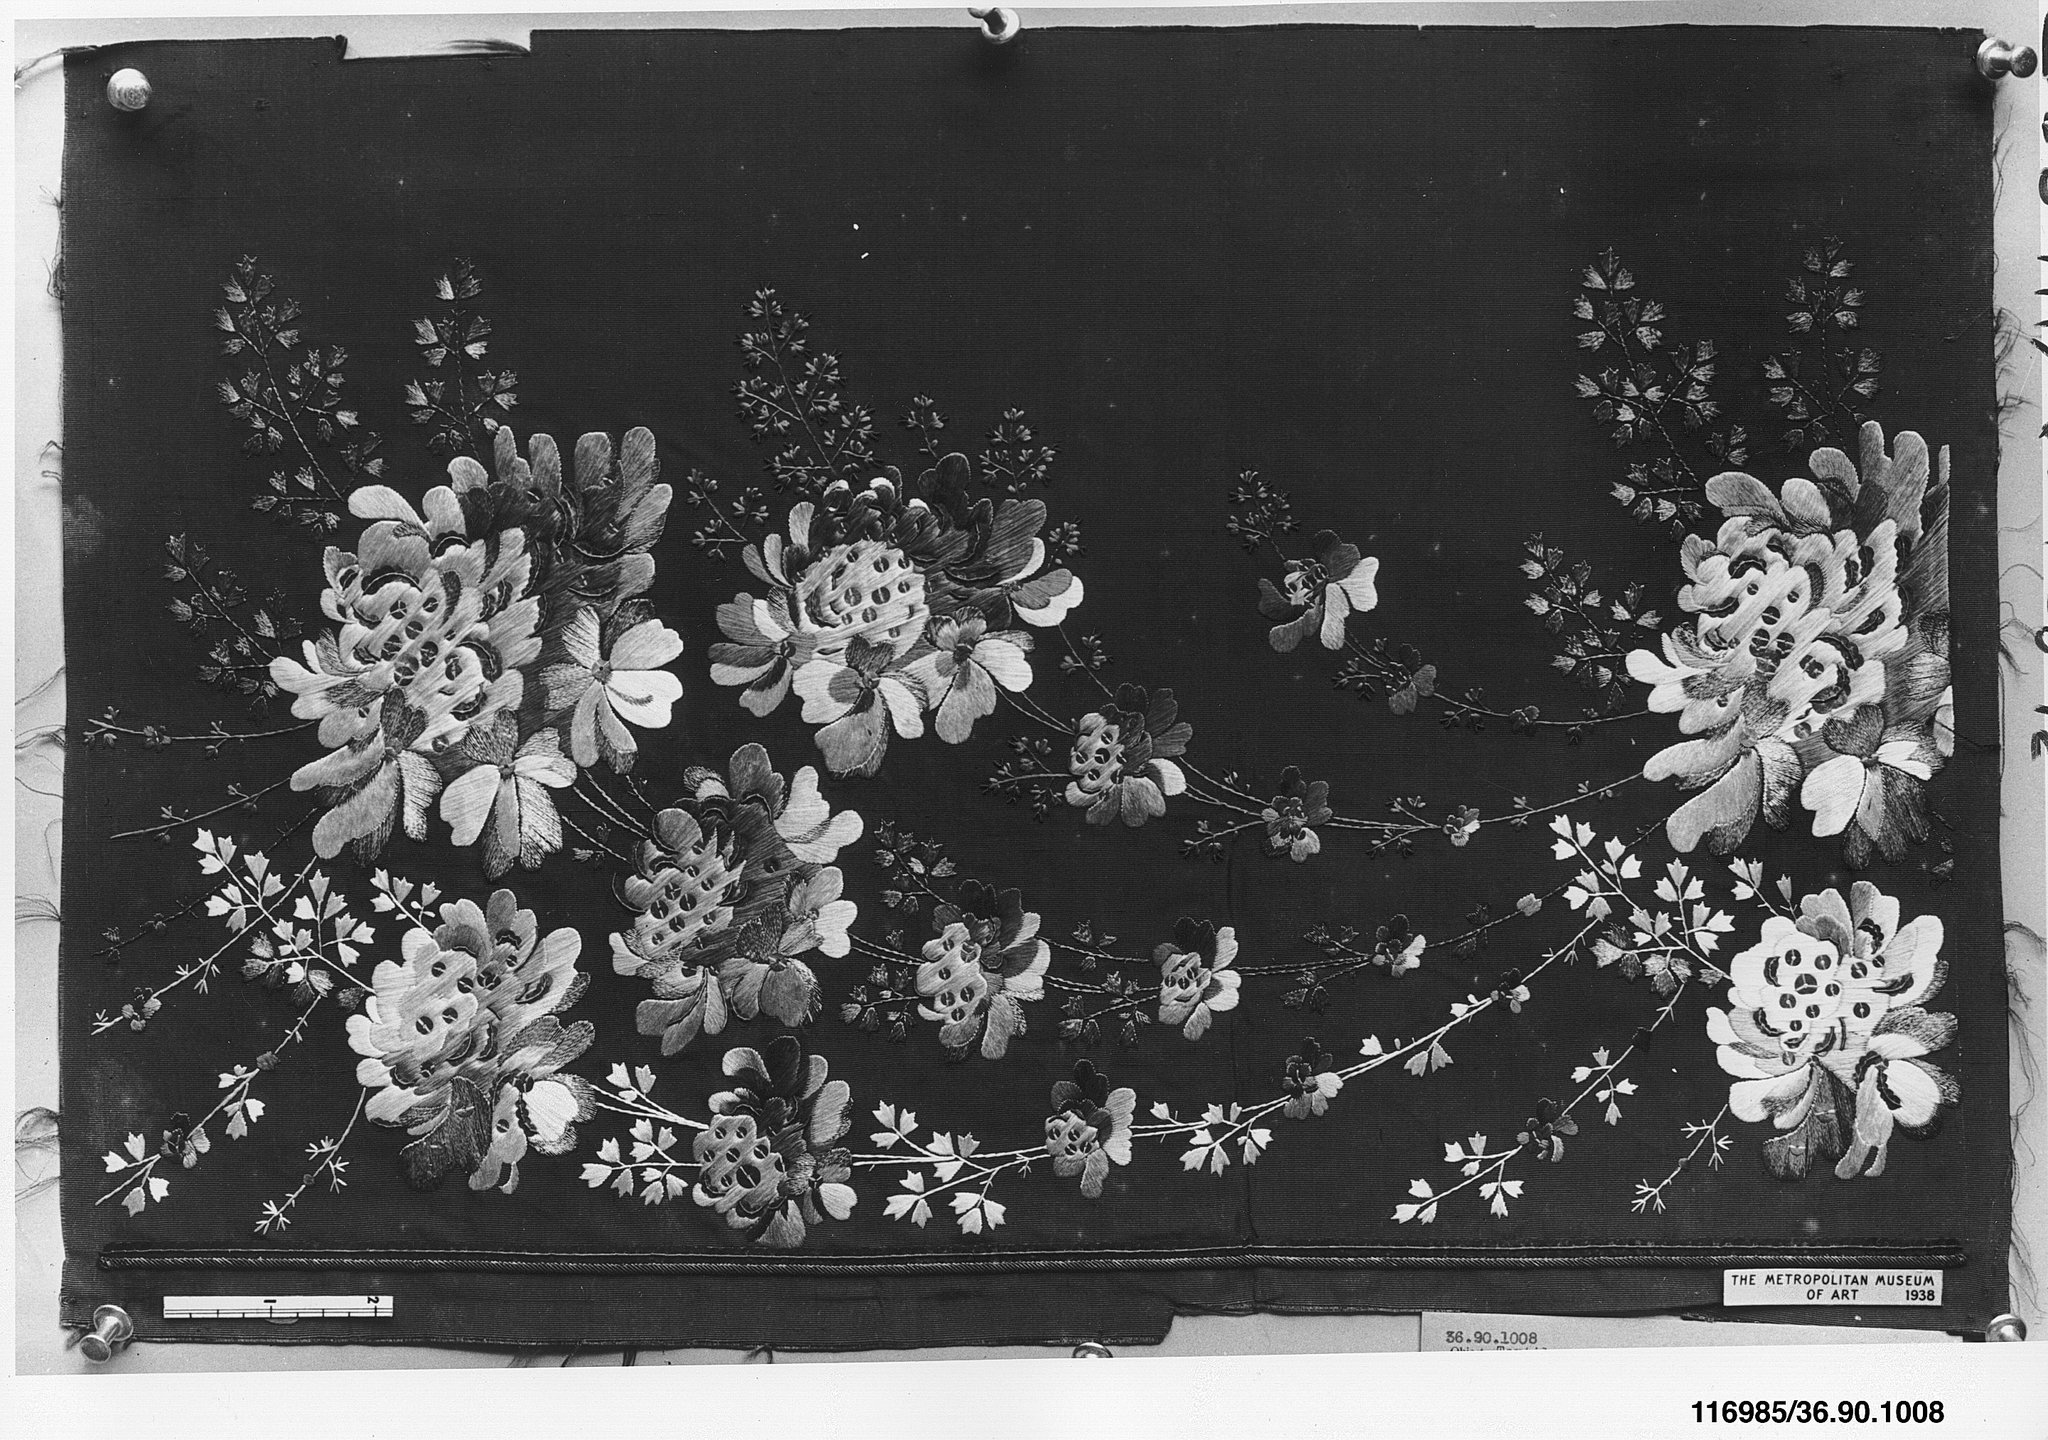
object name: border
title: Dress Border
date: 1801-1833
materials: metal thread, silk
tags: flowers